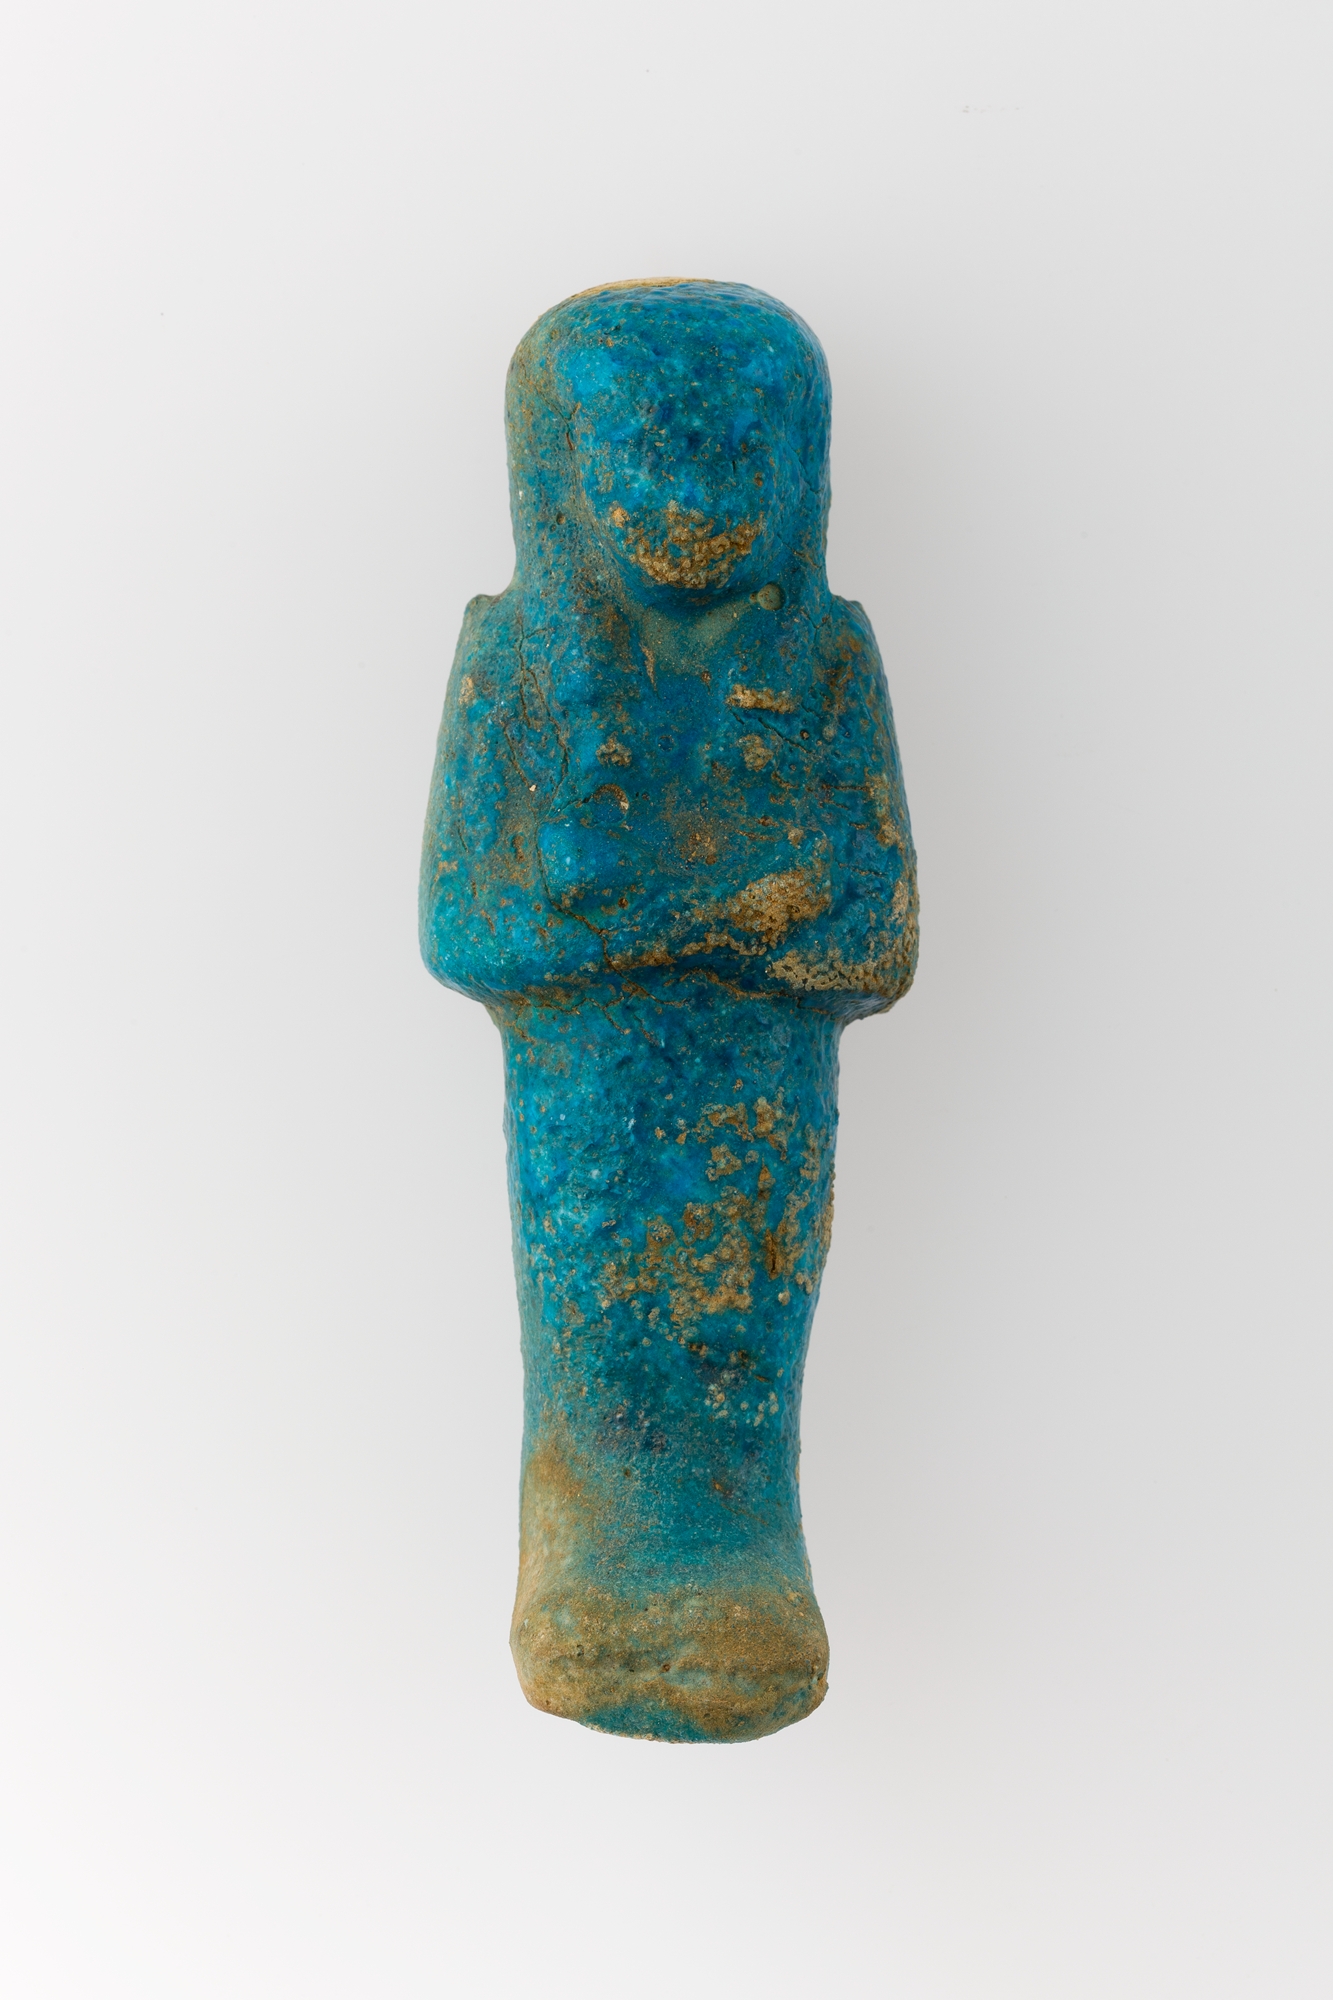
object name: shabti, henettawy c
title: Worker Shabti of Henettawy (C), Daughter of Isetemkheb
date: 990-970 BCE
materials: faience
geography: egypt